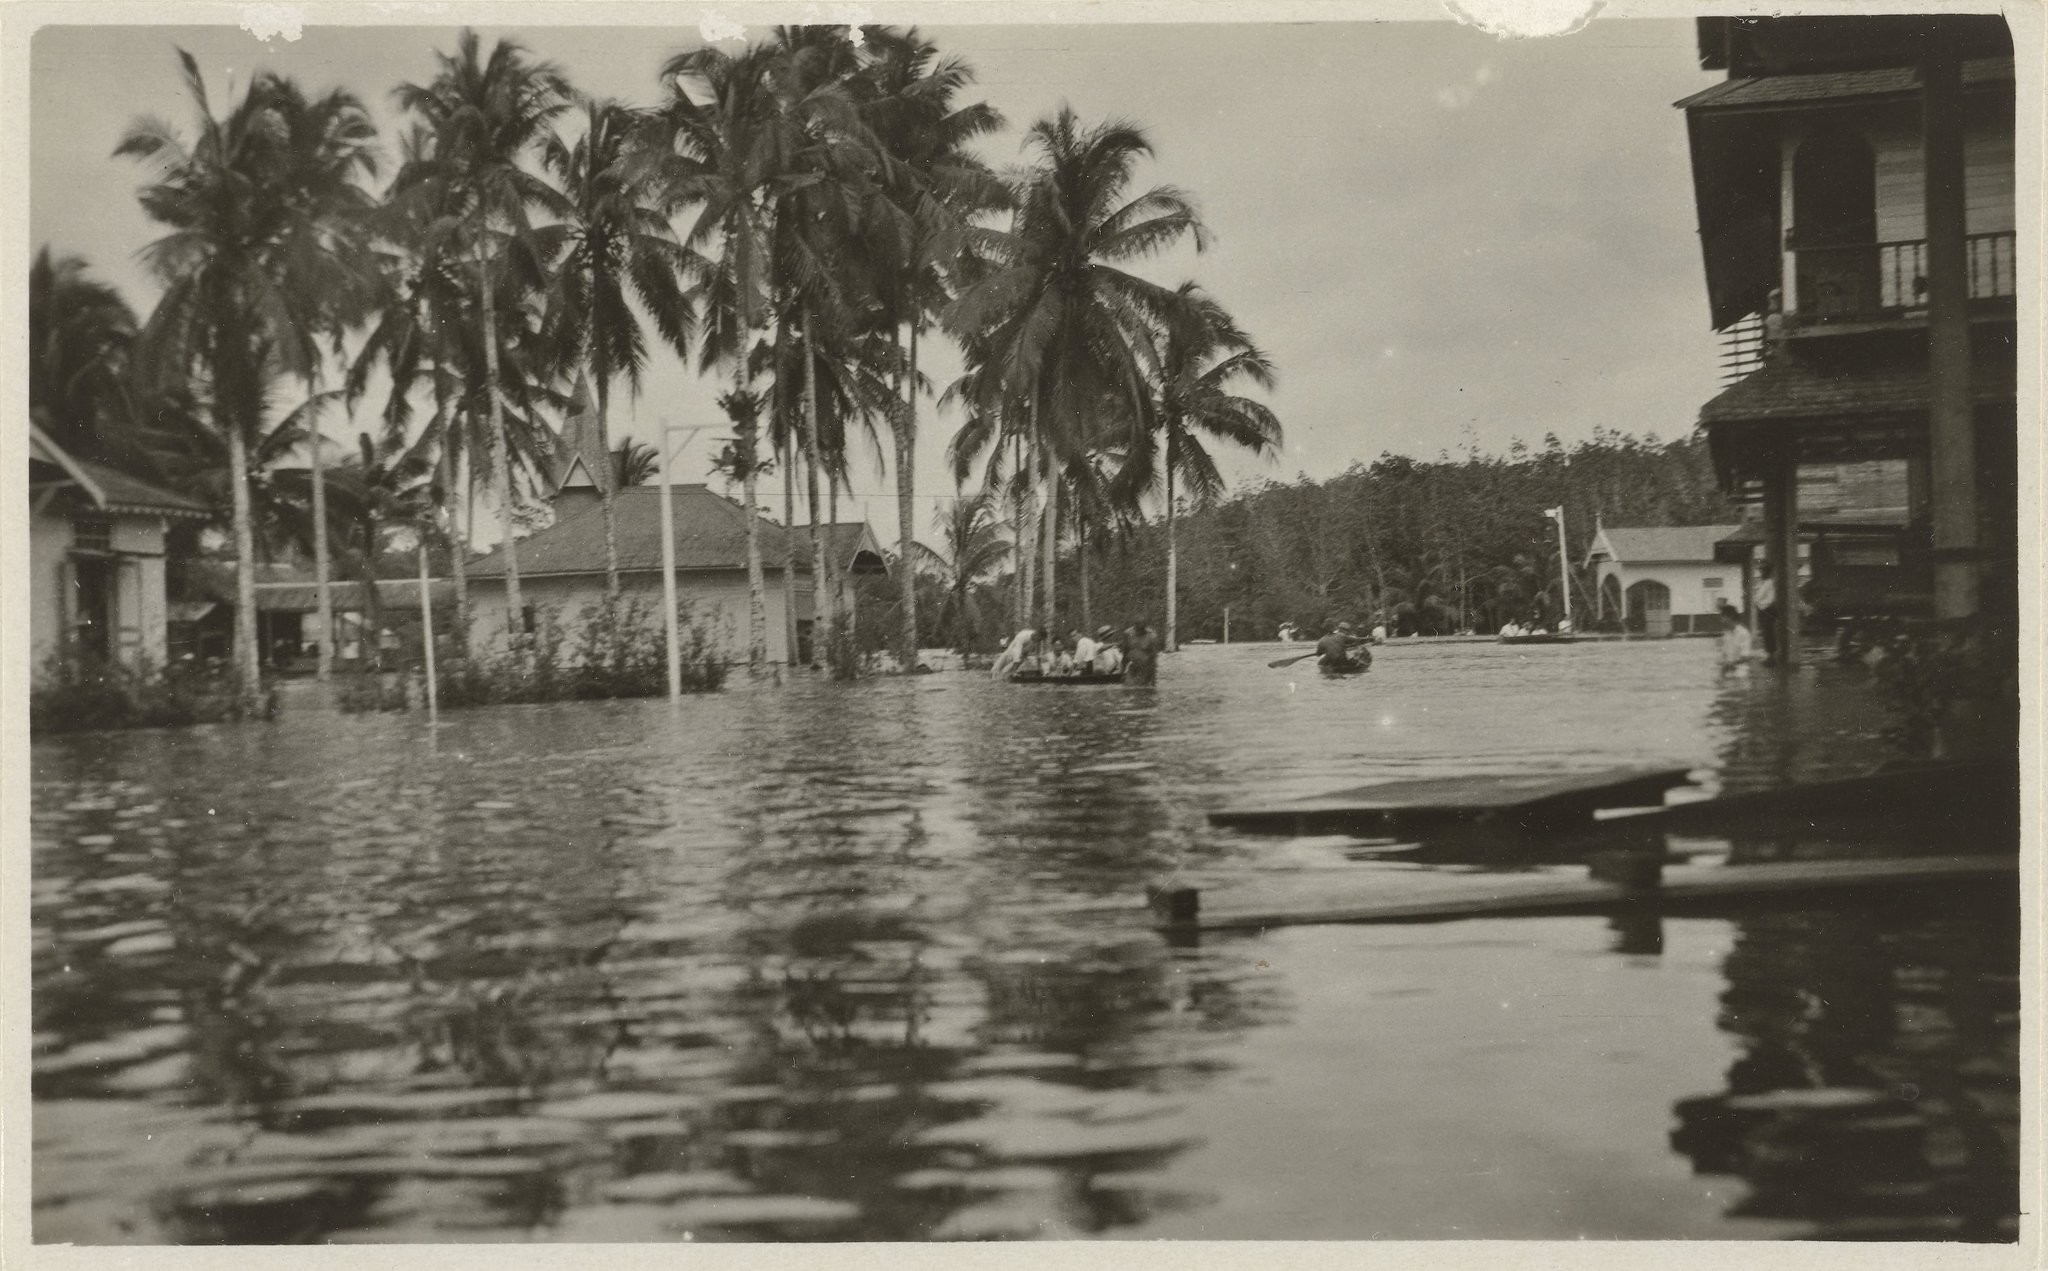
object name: photograph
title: Wateroverlast in de straten van Singkawang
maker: Anonymous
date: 1920-1940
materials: photographic support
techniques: gelatin silver print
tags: borneo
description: Onder water gelopen straat in Singkawang waardoor mensen met boten door de straten varen